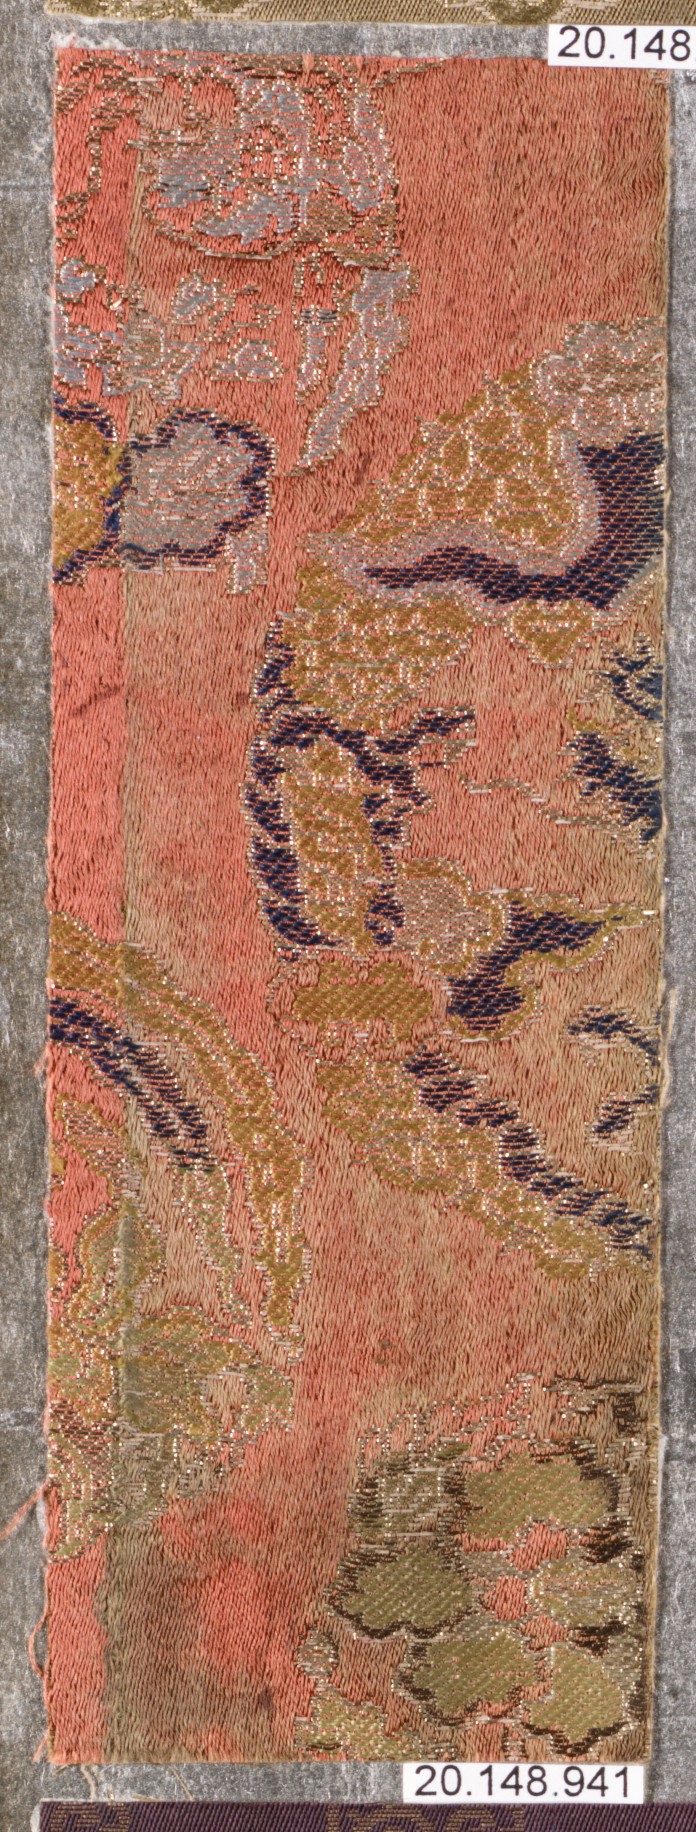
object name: piece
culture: japanese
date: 1601-1700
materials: silk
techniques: compound weave